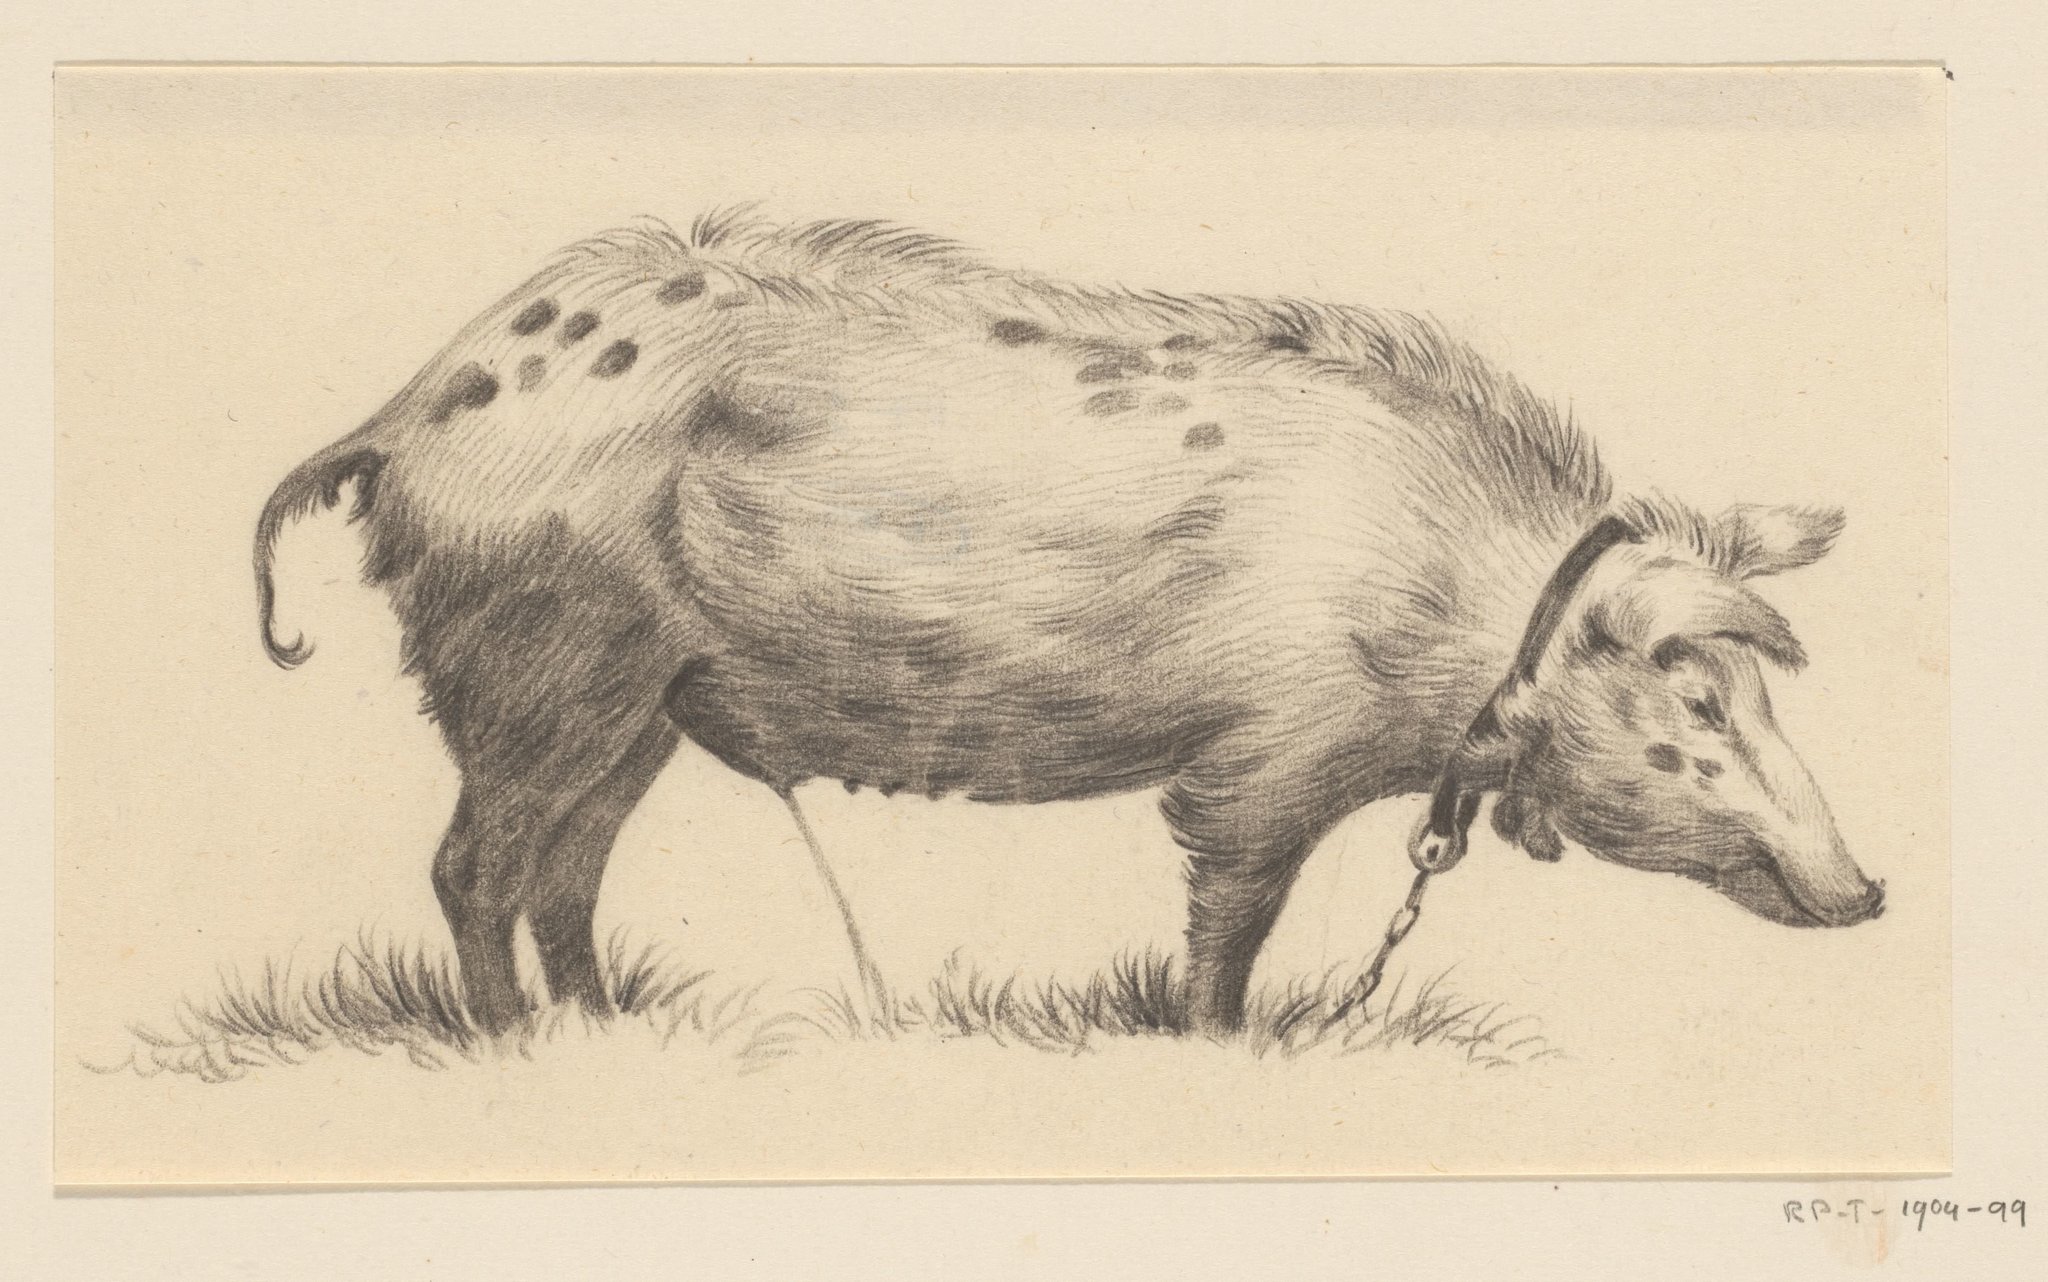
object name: drawing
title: Staand waterend varken, naar rechts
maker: jean bernard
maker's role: draughtsman, print maker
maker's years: 1765-1833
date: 1775-1833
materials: chalk, paper, pencil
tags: pig (+ animal excreting)